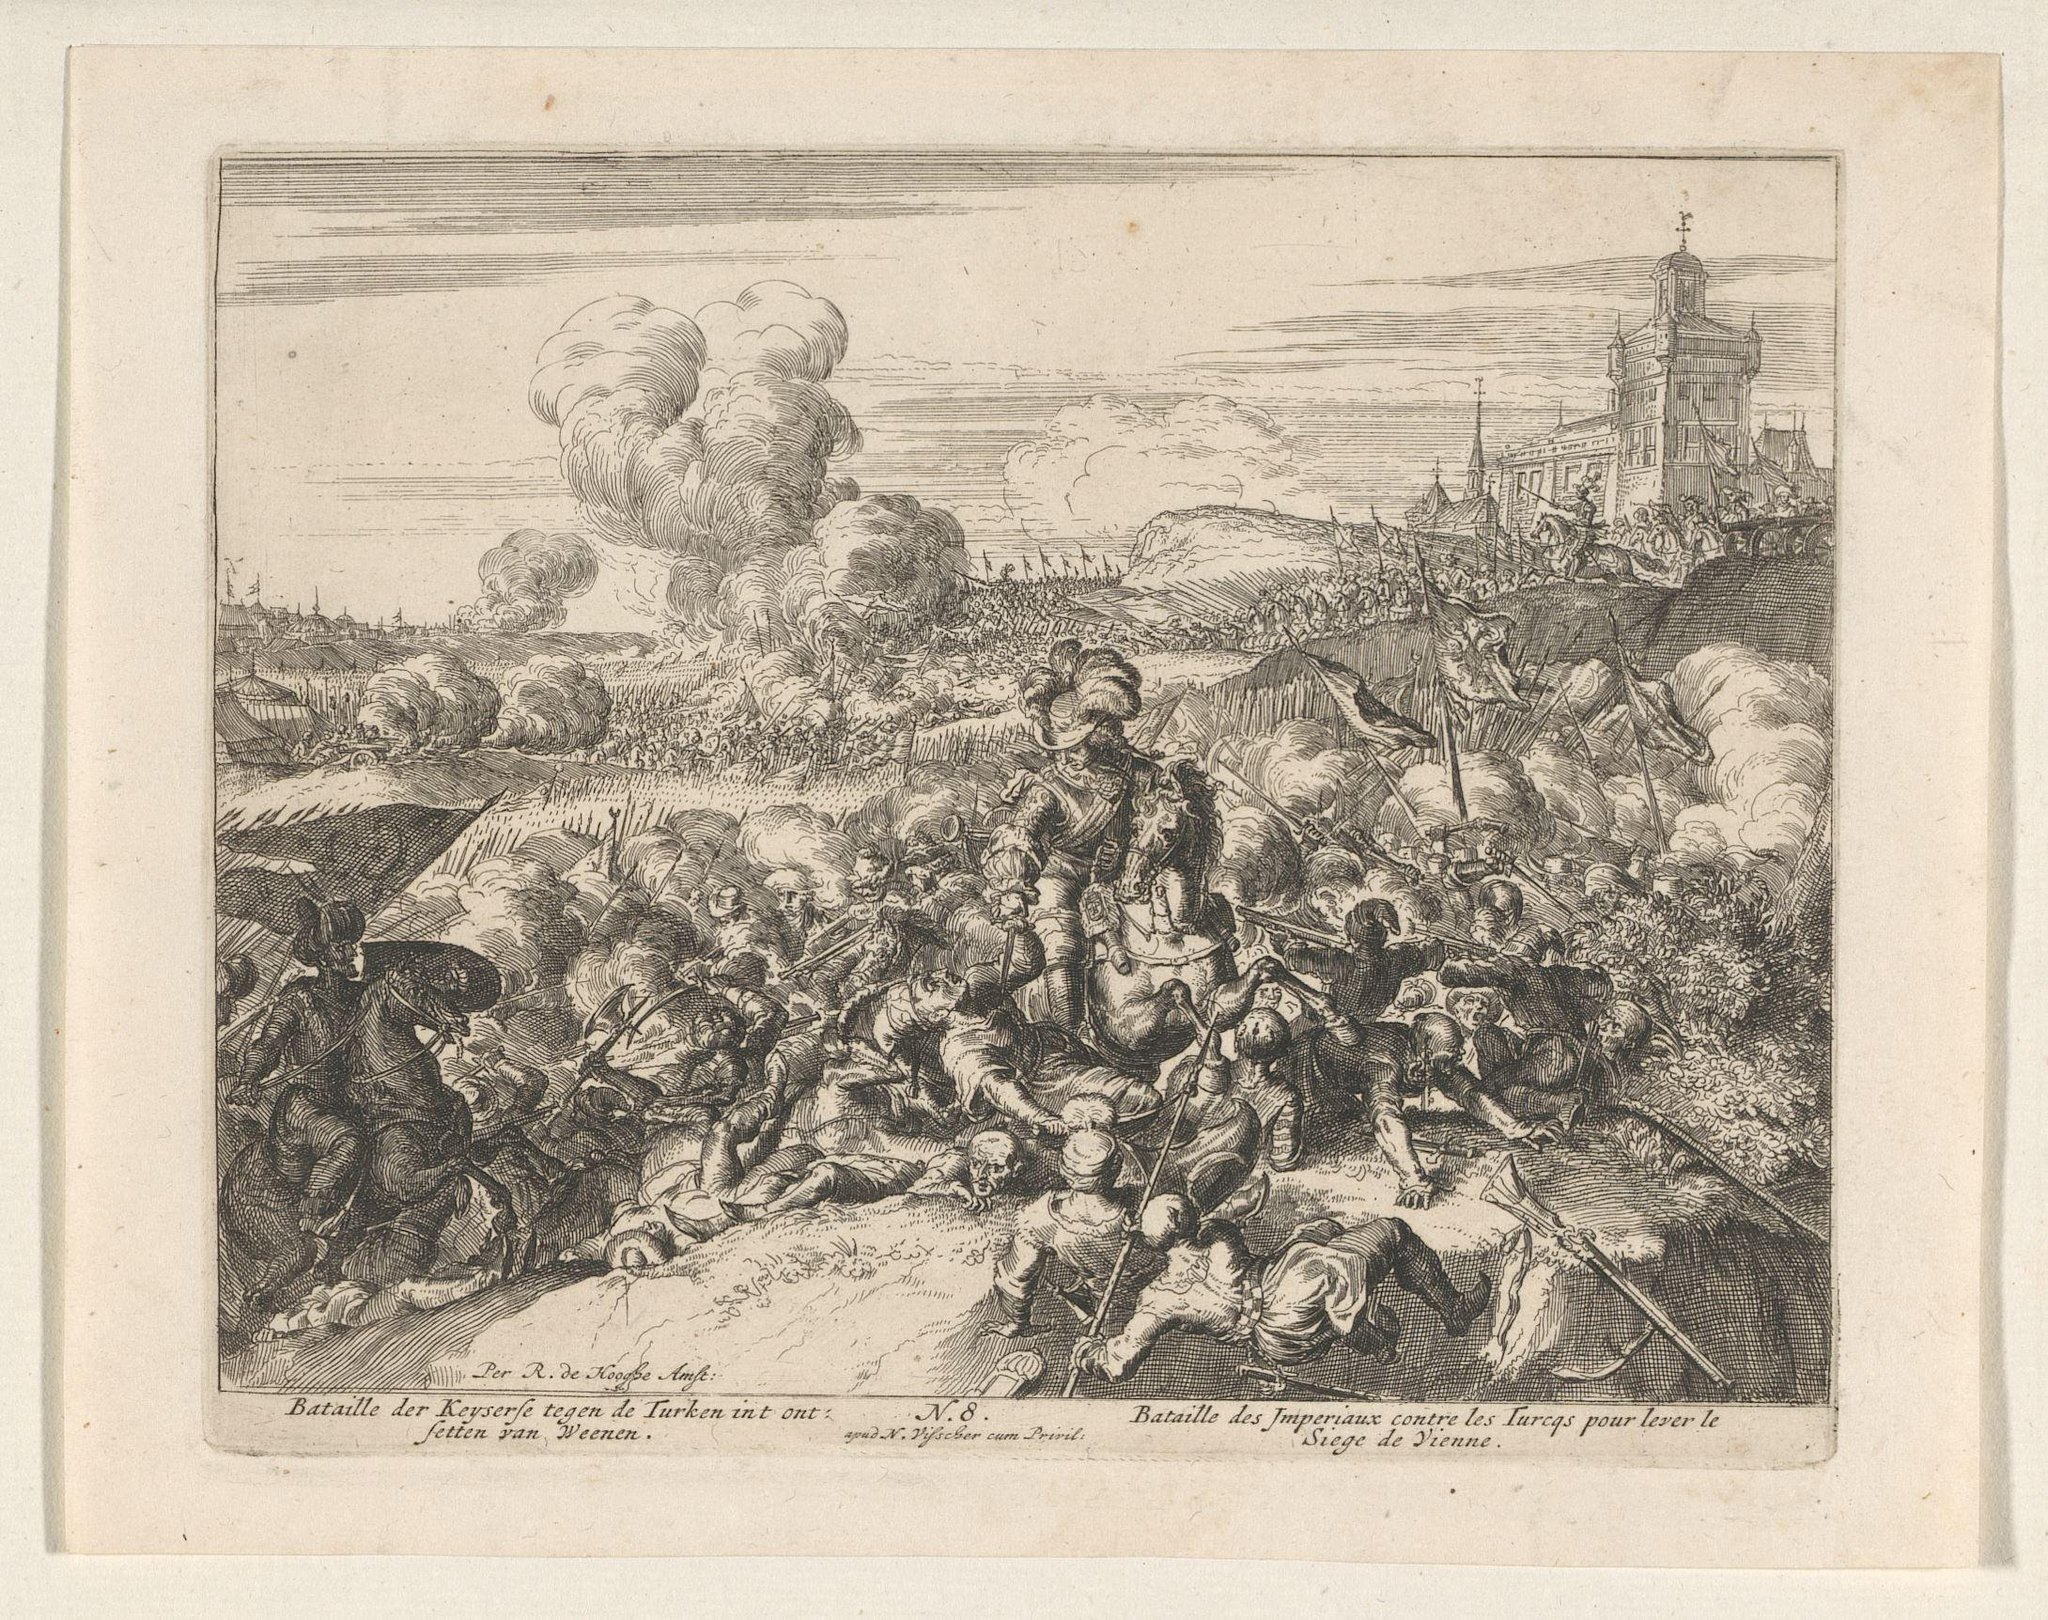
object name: print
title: Bataille der Keyserse tegen de Turken int ontsetten van Weenen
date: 1684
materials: paper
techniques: etching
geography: amsterdam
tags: jan iii sobieski (koning van polen), vienna, leopold i (keizer van duitsland), raising the siege with outside assistance, relief, battle, fighting in general, violent death, being killed; being mishandled and maltreated; seeking death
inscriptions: collector's mark: Lugt 2228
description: Illustratie voor Johann van Ghelen, Relation succinte et veritable de tout ce qui s'est passé pendant le siege de Vienne, residence de Sa Majesté Imperiale, assiegée par les Turcs depuis le 14. juillet jusqu'au 12. de septembre 1683., Bruxelles: Jean Leonard, 1684.